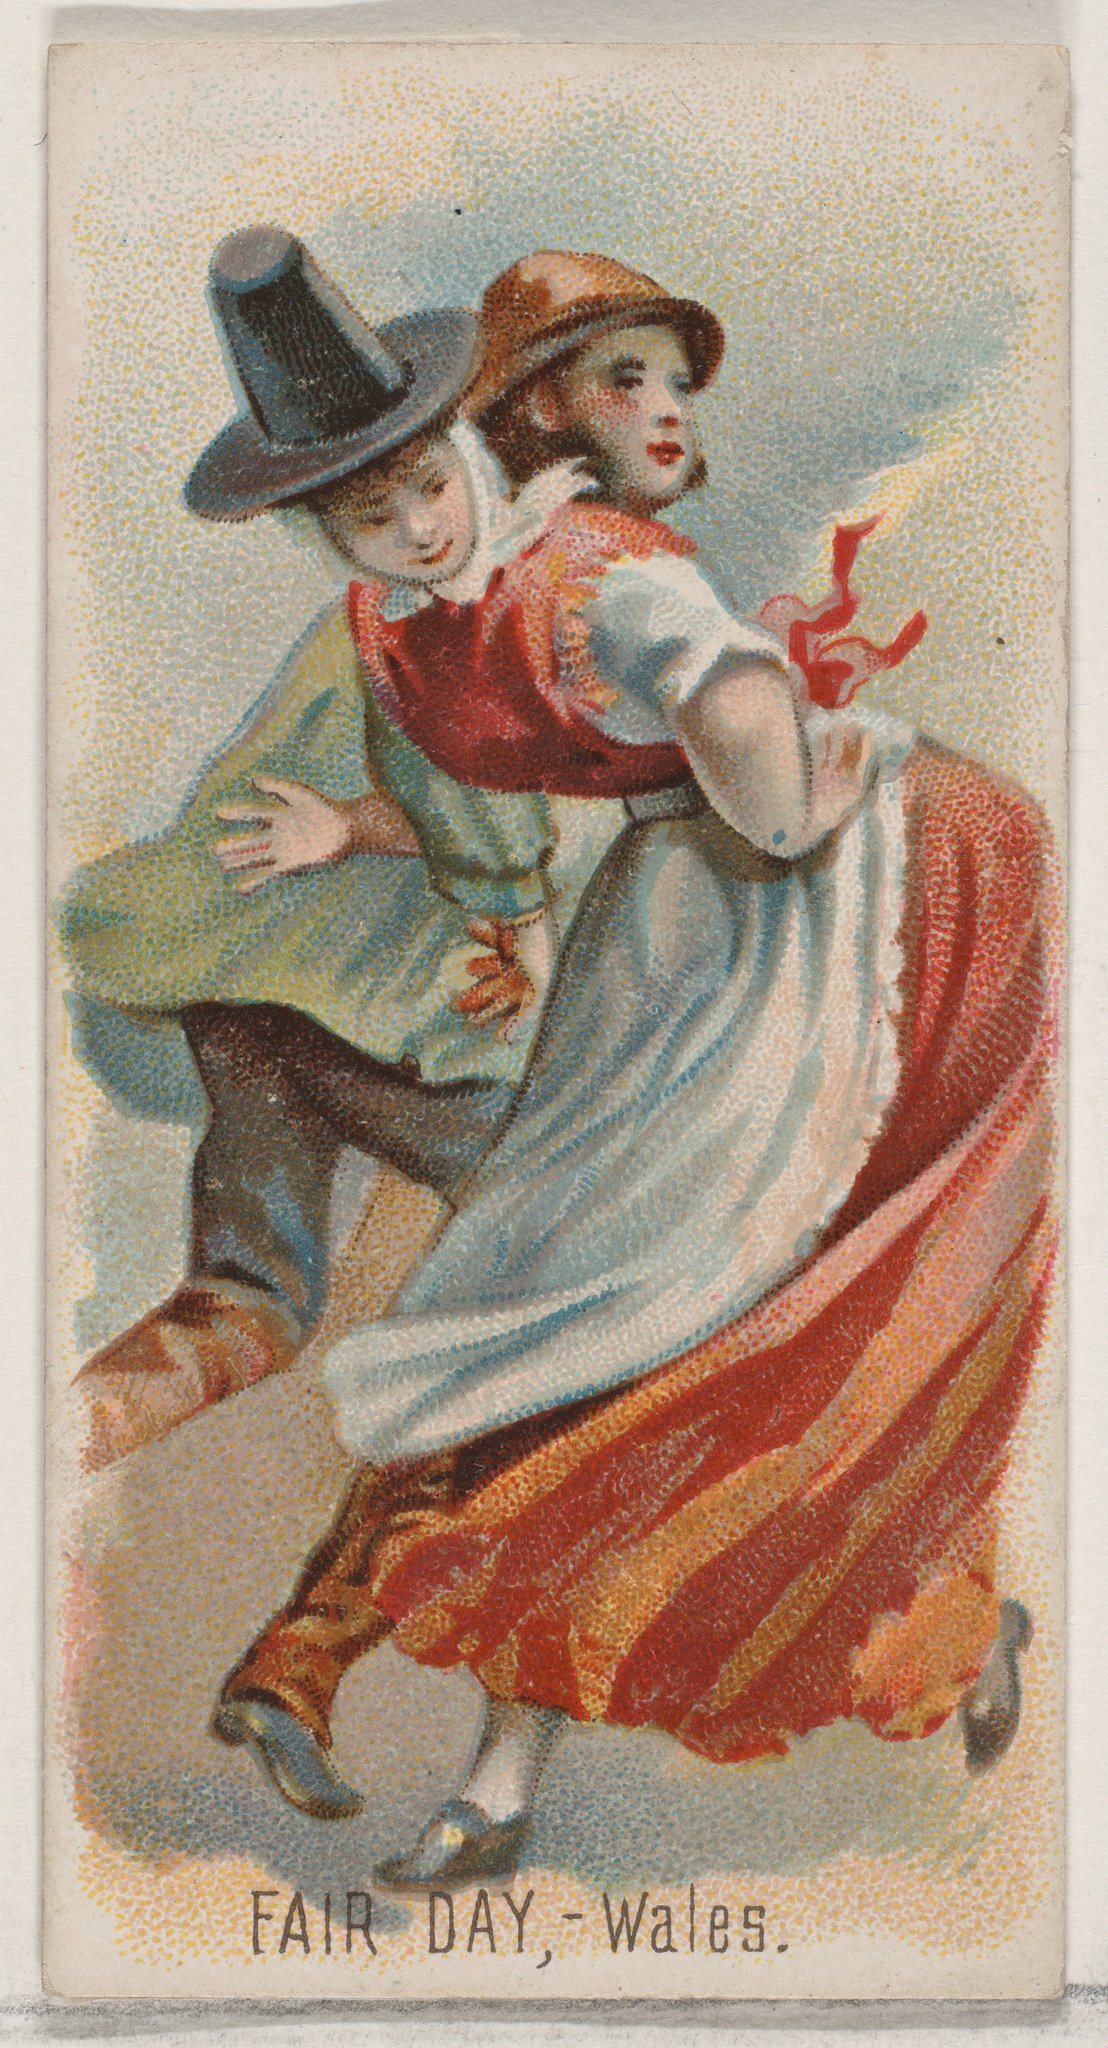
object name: print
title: Fair Day, Wales, from the Holidays series (N80) for Duke brand cigarettes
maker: w. duke, sons & co.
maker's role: publisher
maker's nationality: american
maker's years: 1870-1920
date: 1890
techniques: color lithograph